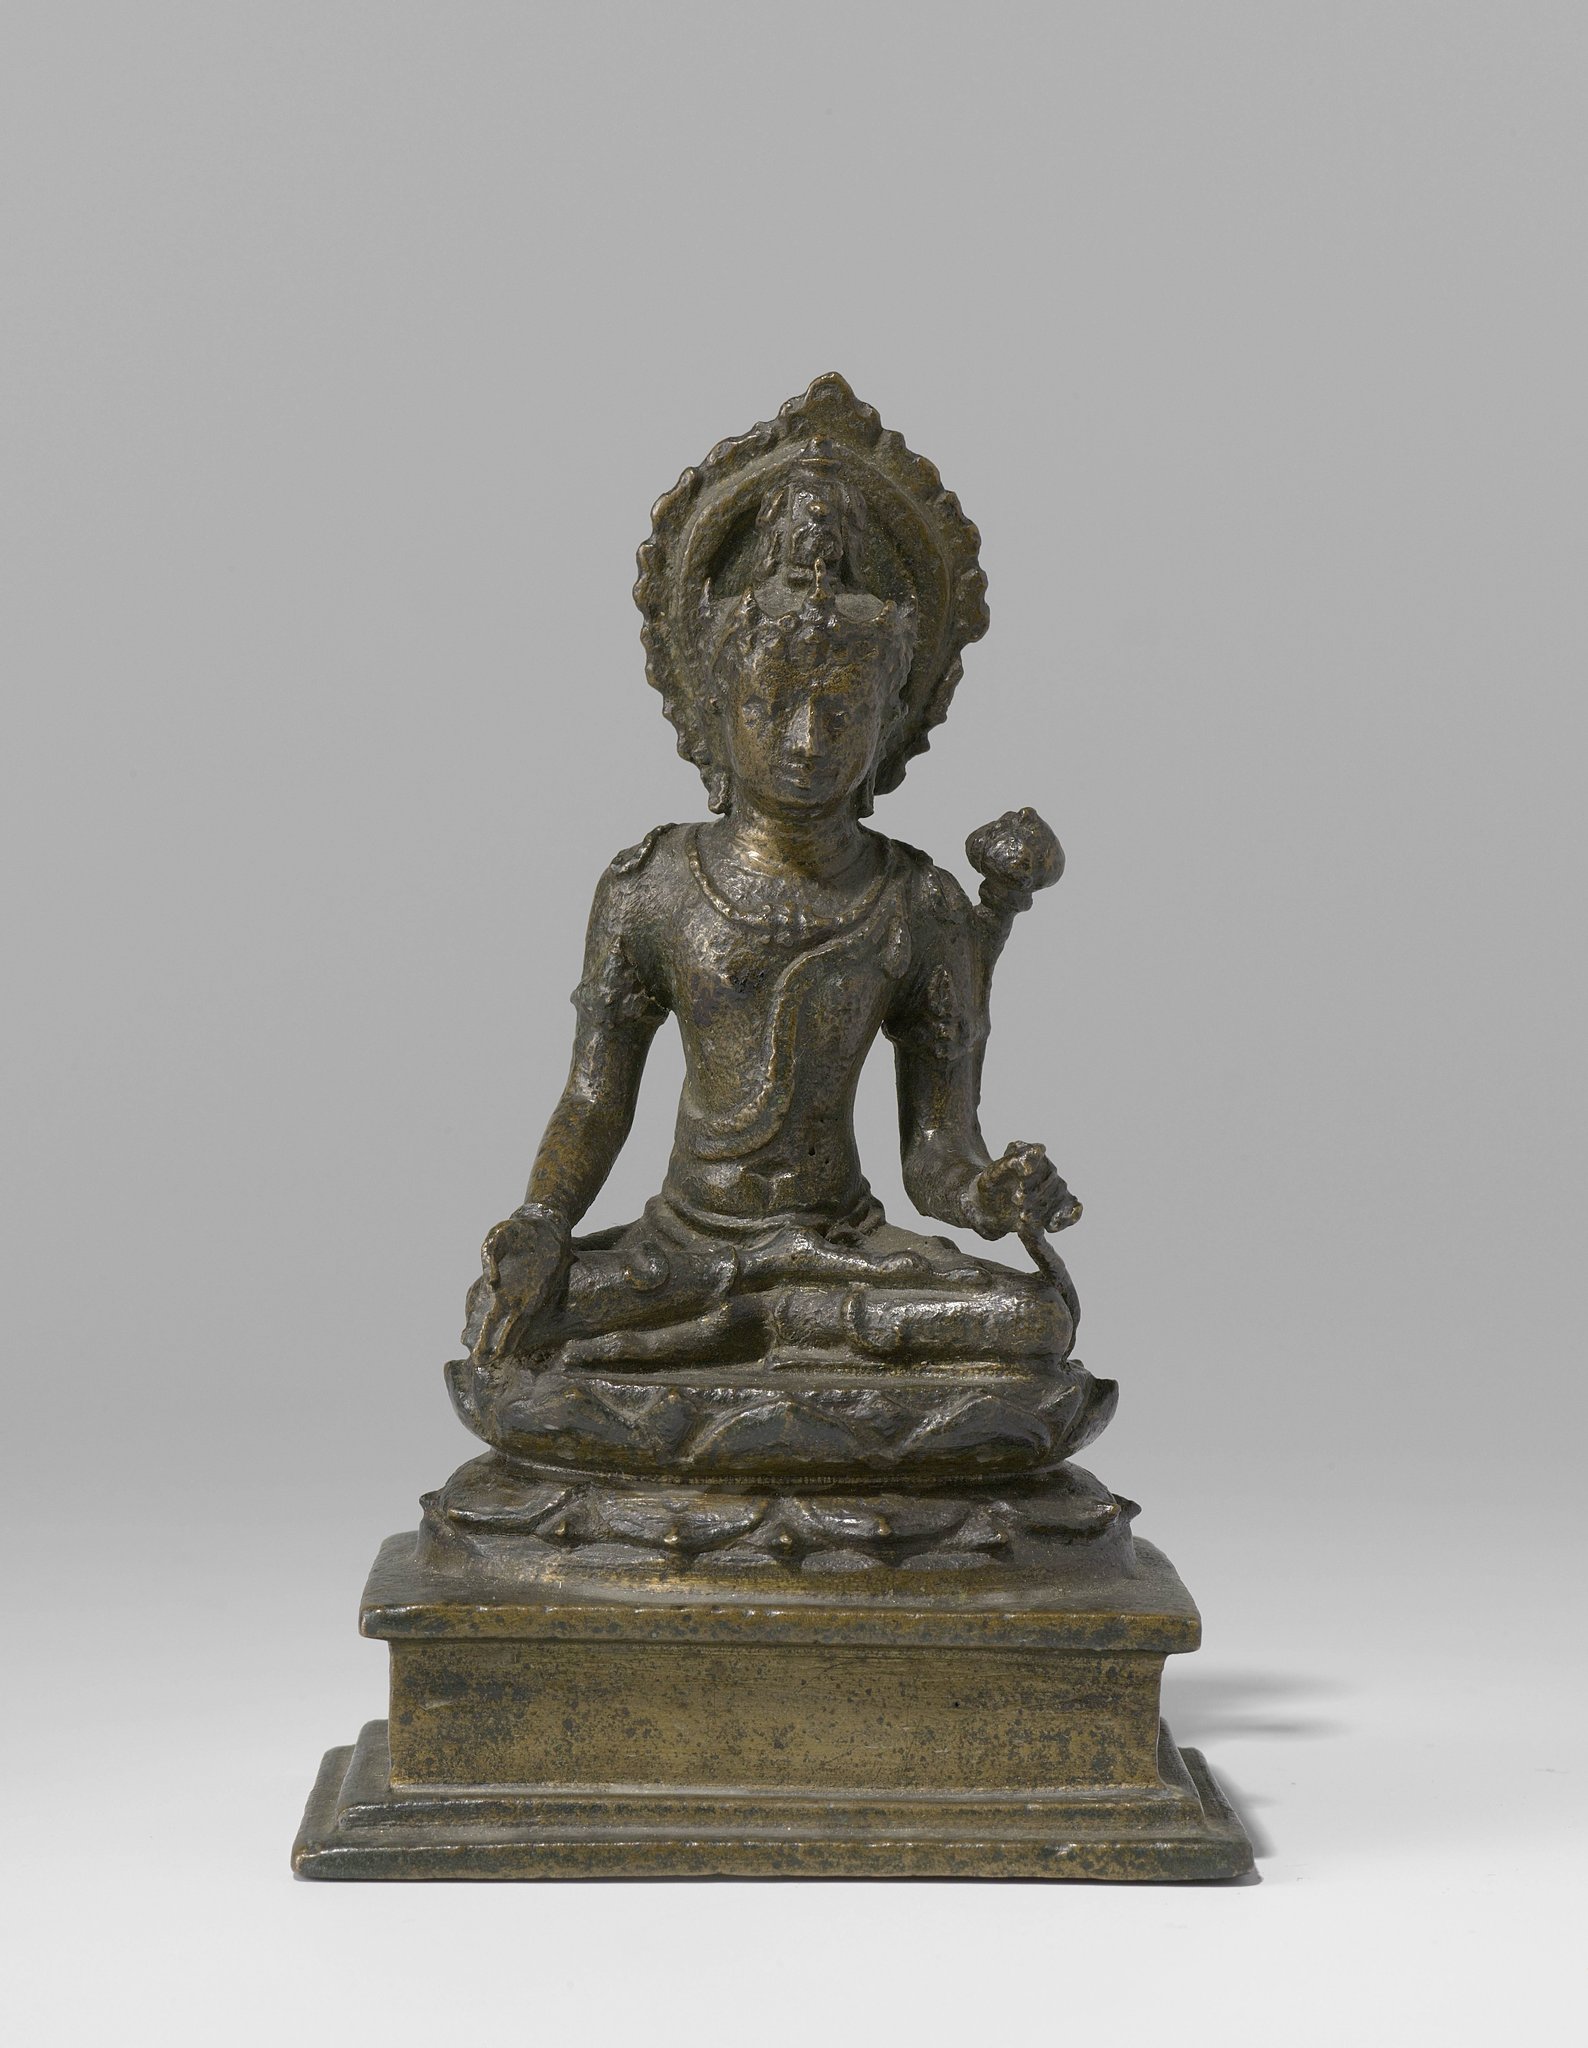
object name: figure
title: Padmapani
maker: Anonymous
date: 850-930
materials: bronze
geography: indonesia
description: Sculptuur van een zittende Padmapani (Avalokitesvara).